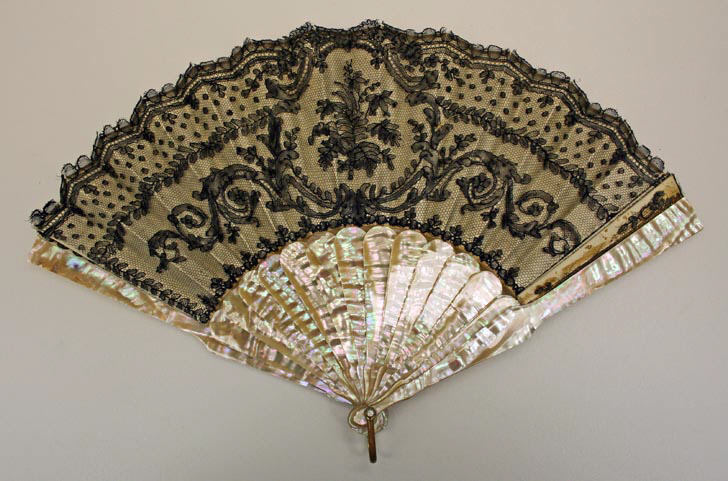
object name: fan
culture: american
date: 1860-1870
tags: flowers